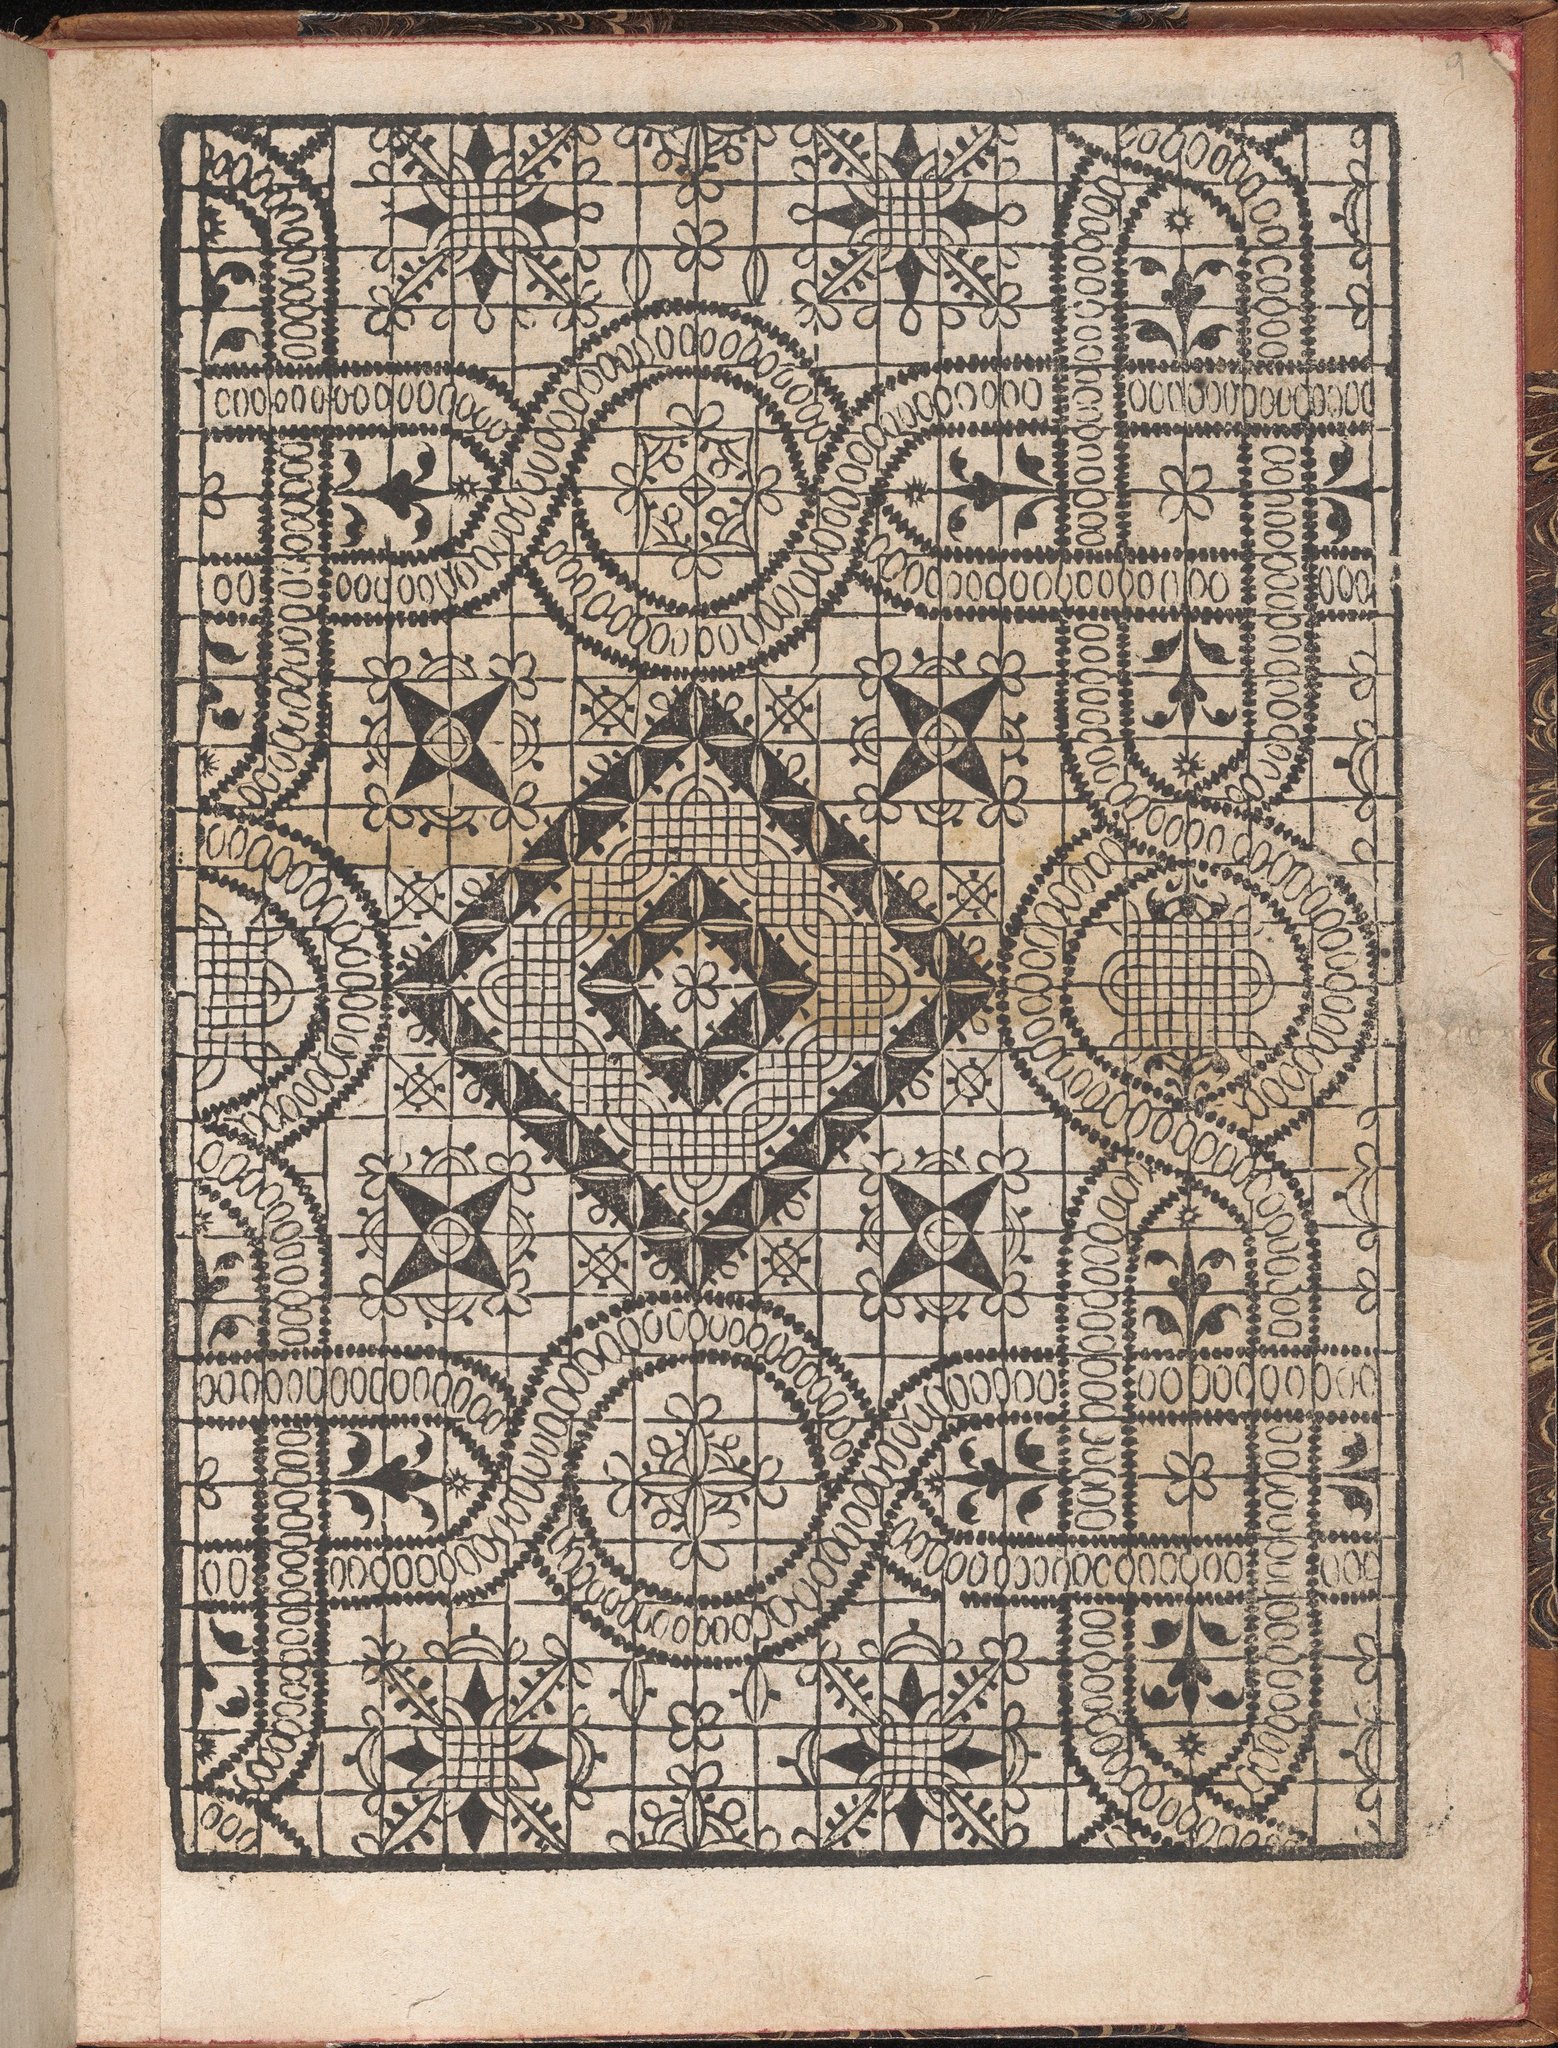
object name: book print ornament architecture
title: Spechio di pensieri delle belle et Virtudiose donne, page 9 (recto)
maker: matteo pagano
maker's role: publisher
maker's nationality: italian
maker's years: 1515-1588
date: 1546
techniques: woodcut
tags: ornament